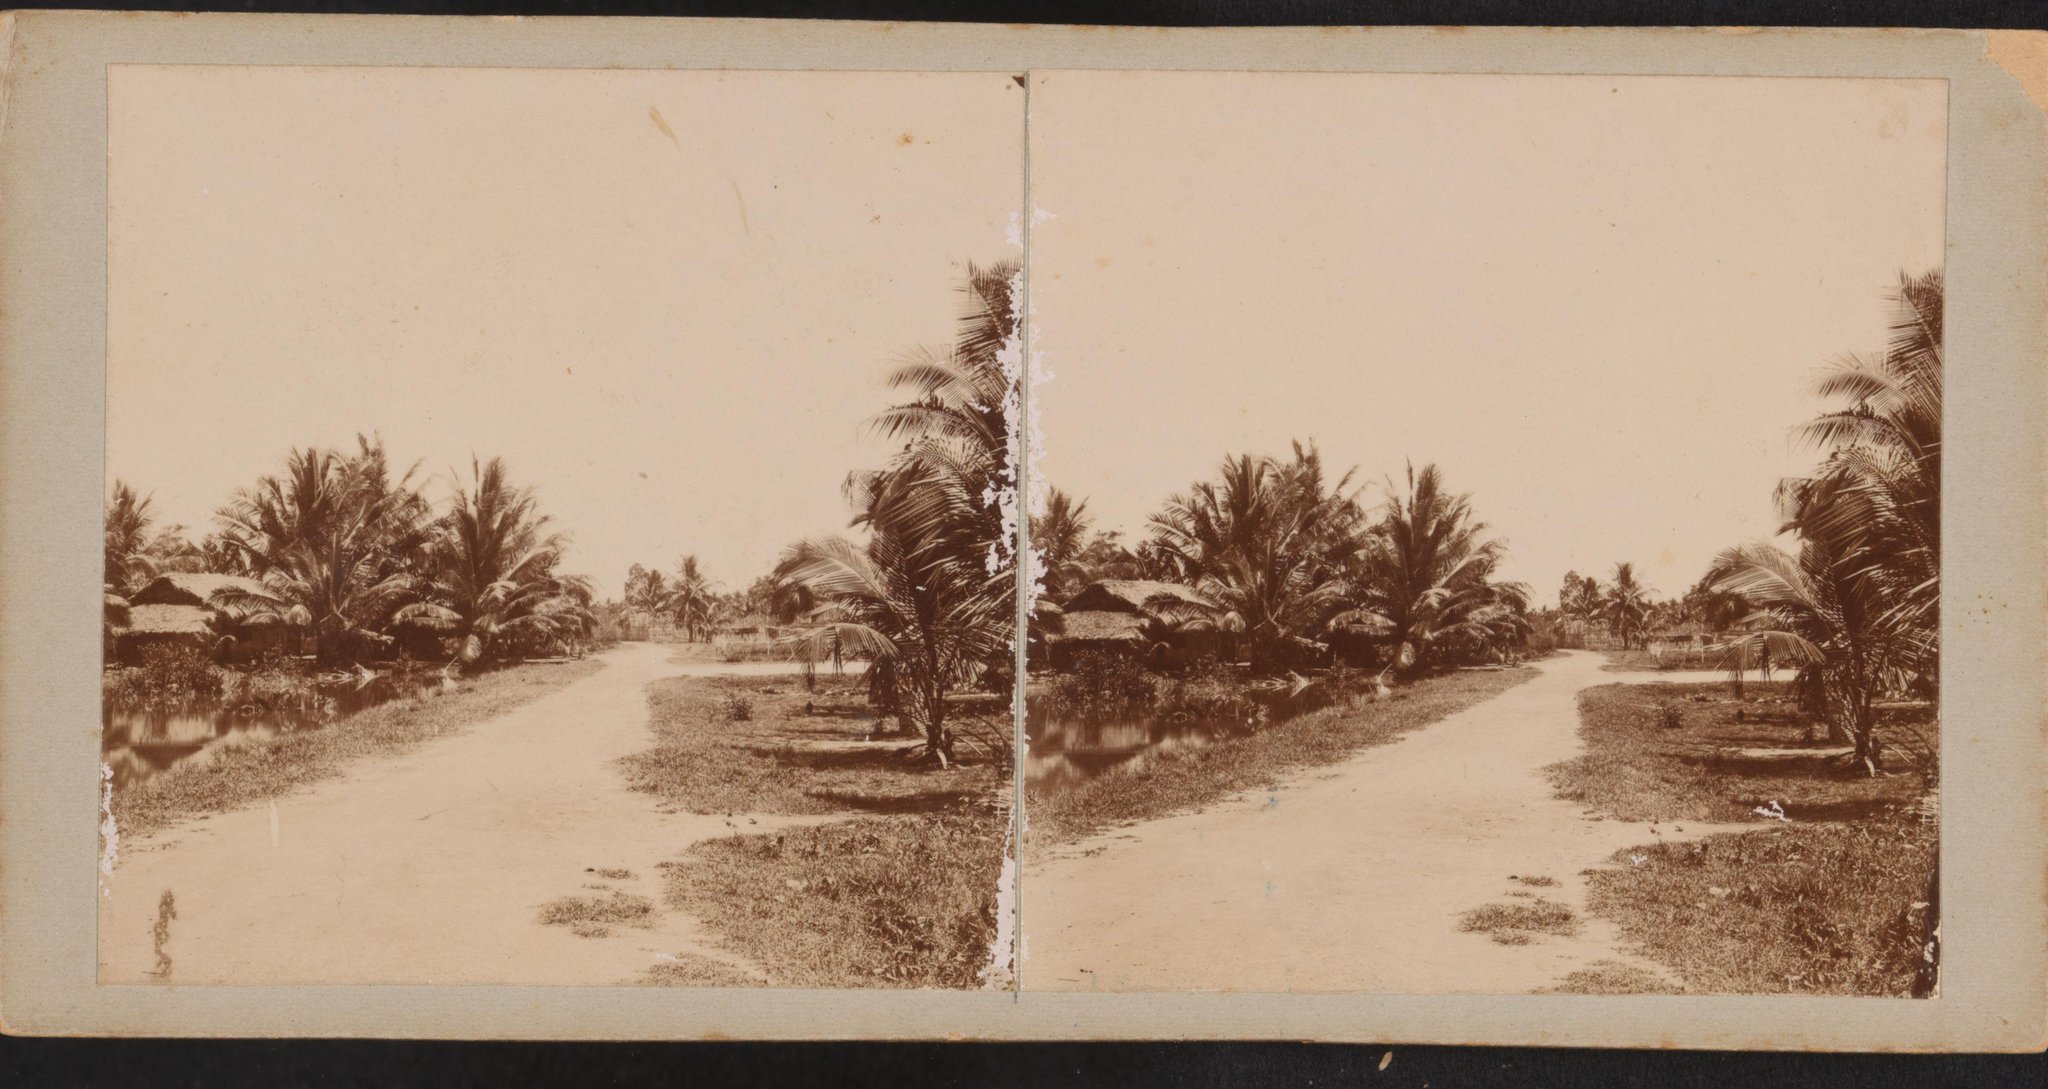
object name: stereograph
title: Weg naar het strand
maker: robert julius boers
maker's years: 1867-1932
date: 1900-1922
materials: cardboard, photographic support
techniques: gelatin silver print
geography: bangka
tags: robert julius boers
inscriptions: inscription: ‘Weg naar het strand Soengei kiat’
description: De weg naar het strand in Soengeiliat op Banka. Onderdeel van een groep stereofoto's van Robert Julius Boers, chef van het staatsbedrijf de Banka-tinwinning op Banka, uit de periode ca. 1900-1922.